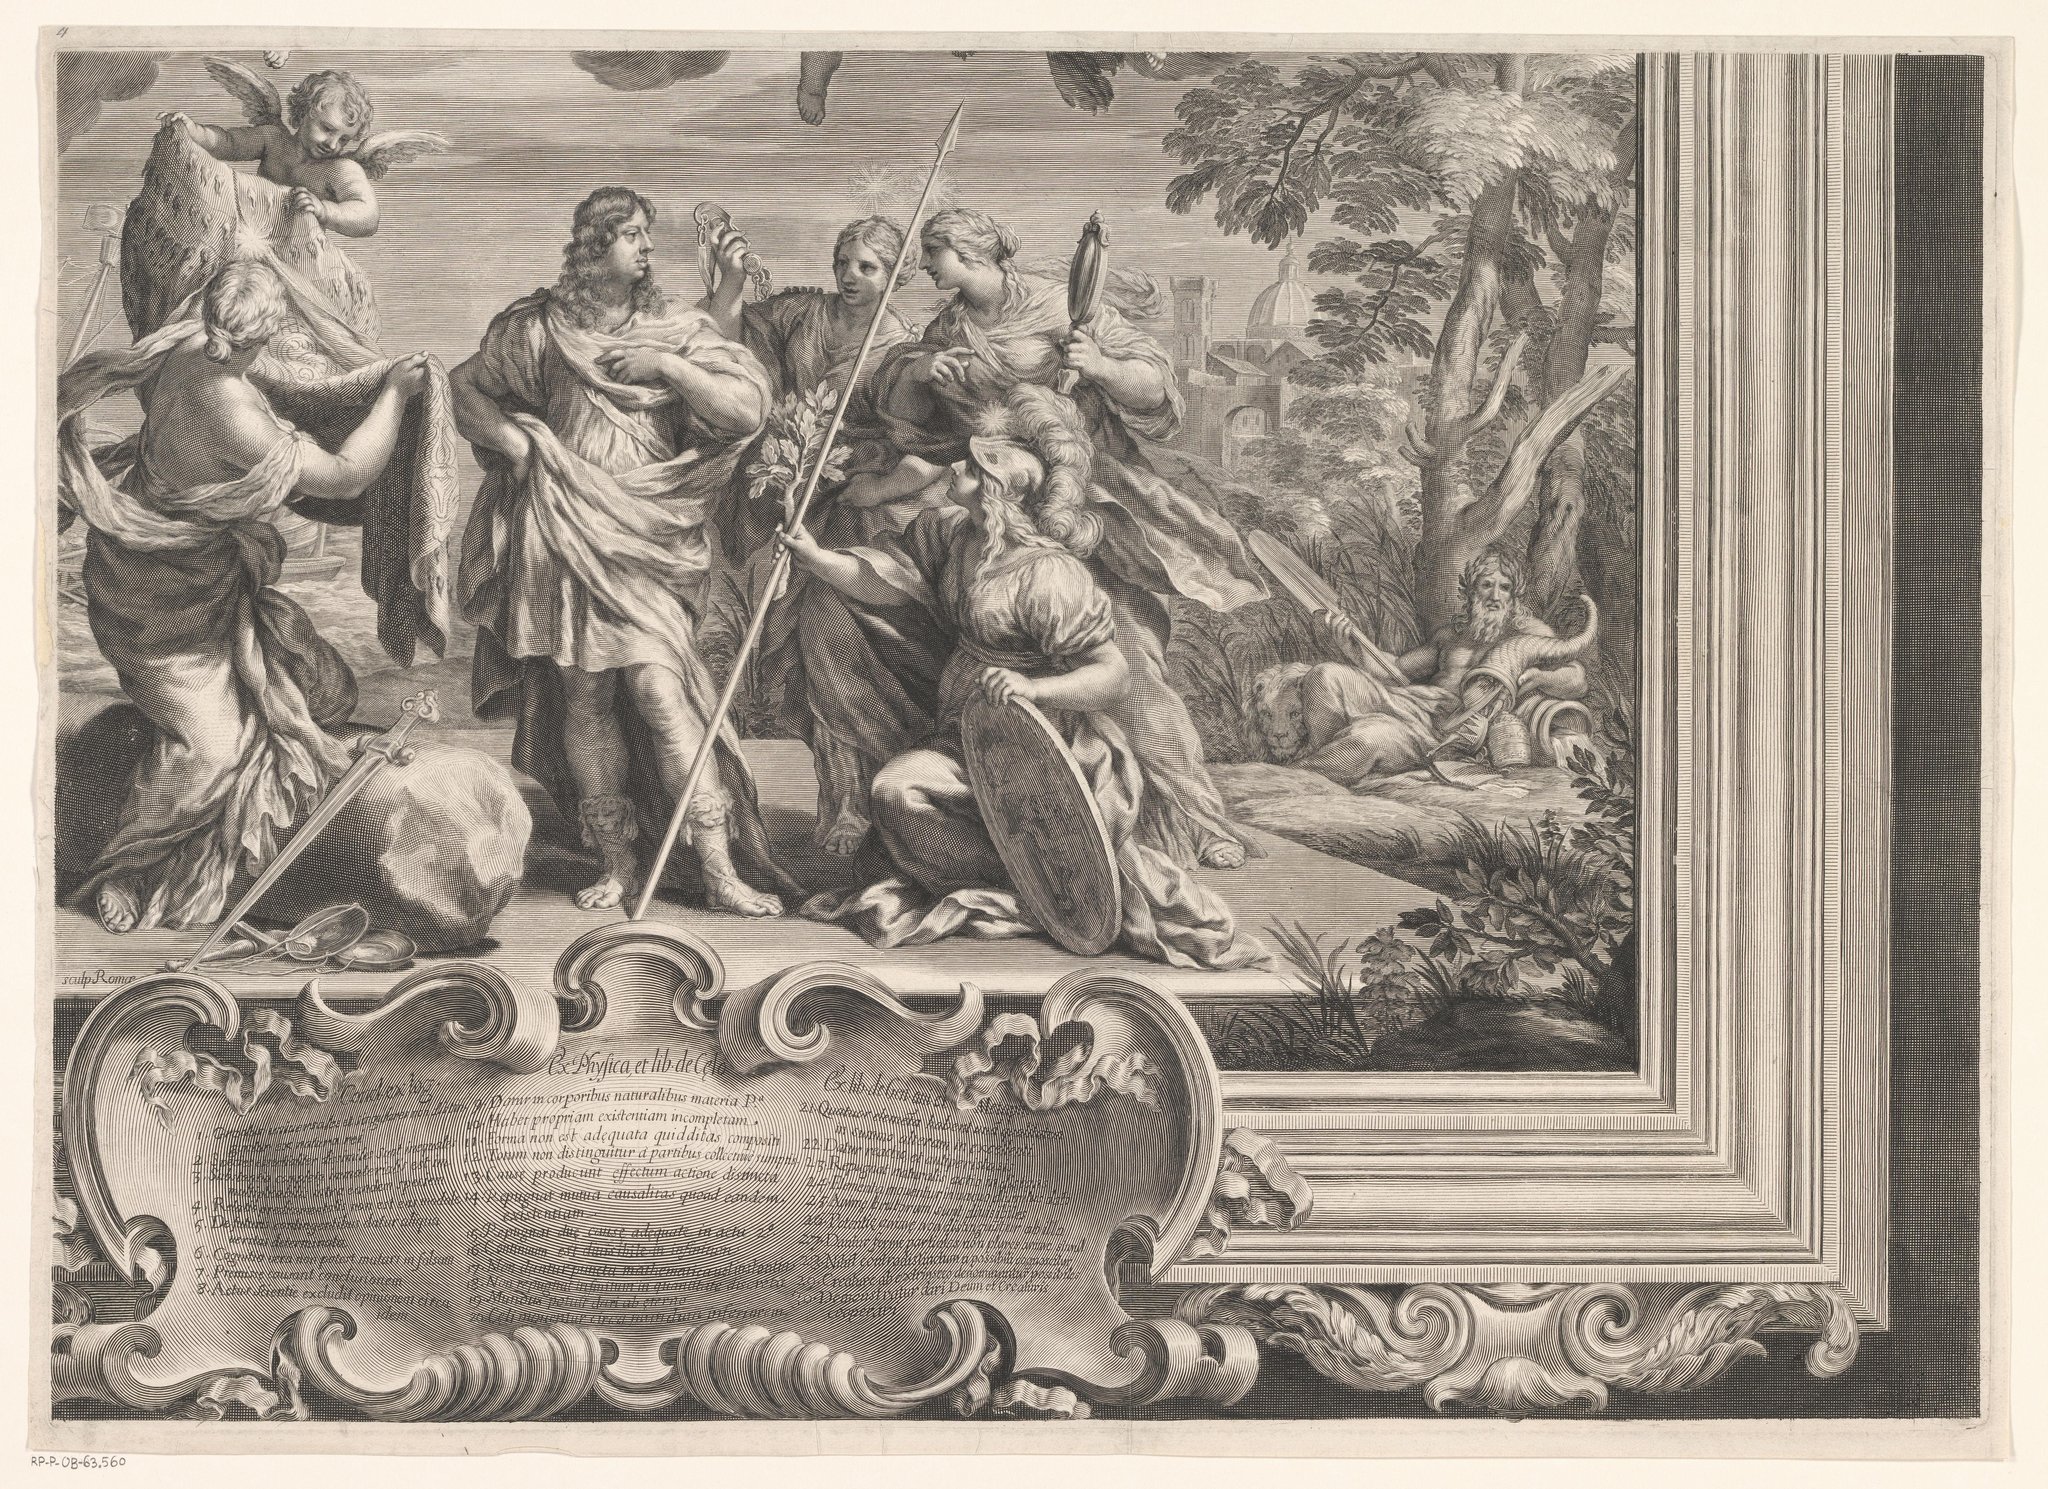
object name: print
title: Allegorie op Cosimo III in monumentale omlijsting (deel rechtsonder)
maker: françois spierre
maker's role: print maker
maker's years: 1639-1681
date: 1649-1681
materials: paper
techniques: engraving, etching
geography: rome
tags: cosimo iii de' medici, 'cornucopia', horn of plenty, (story of) minerva (pallas, athena), historical persons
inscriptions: collector's mark: Lugt 2228